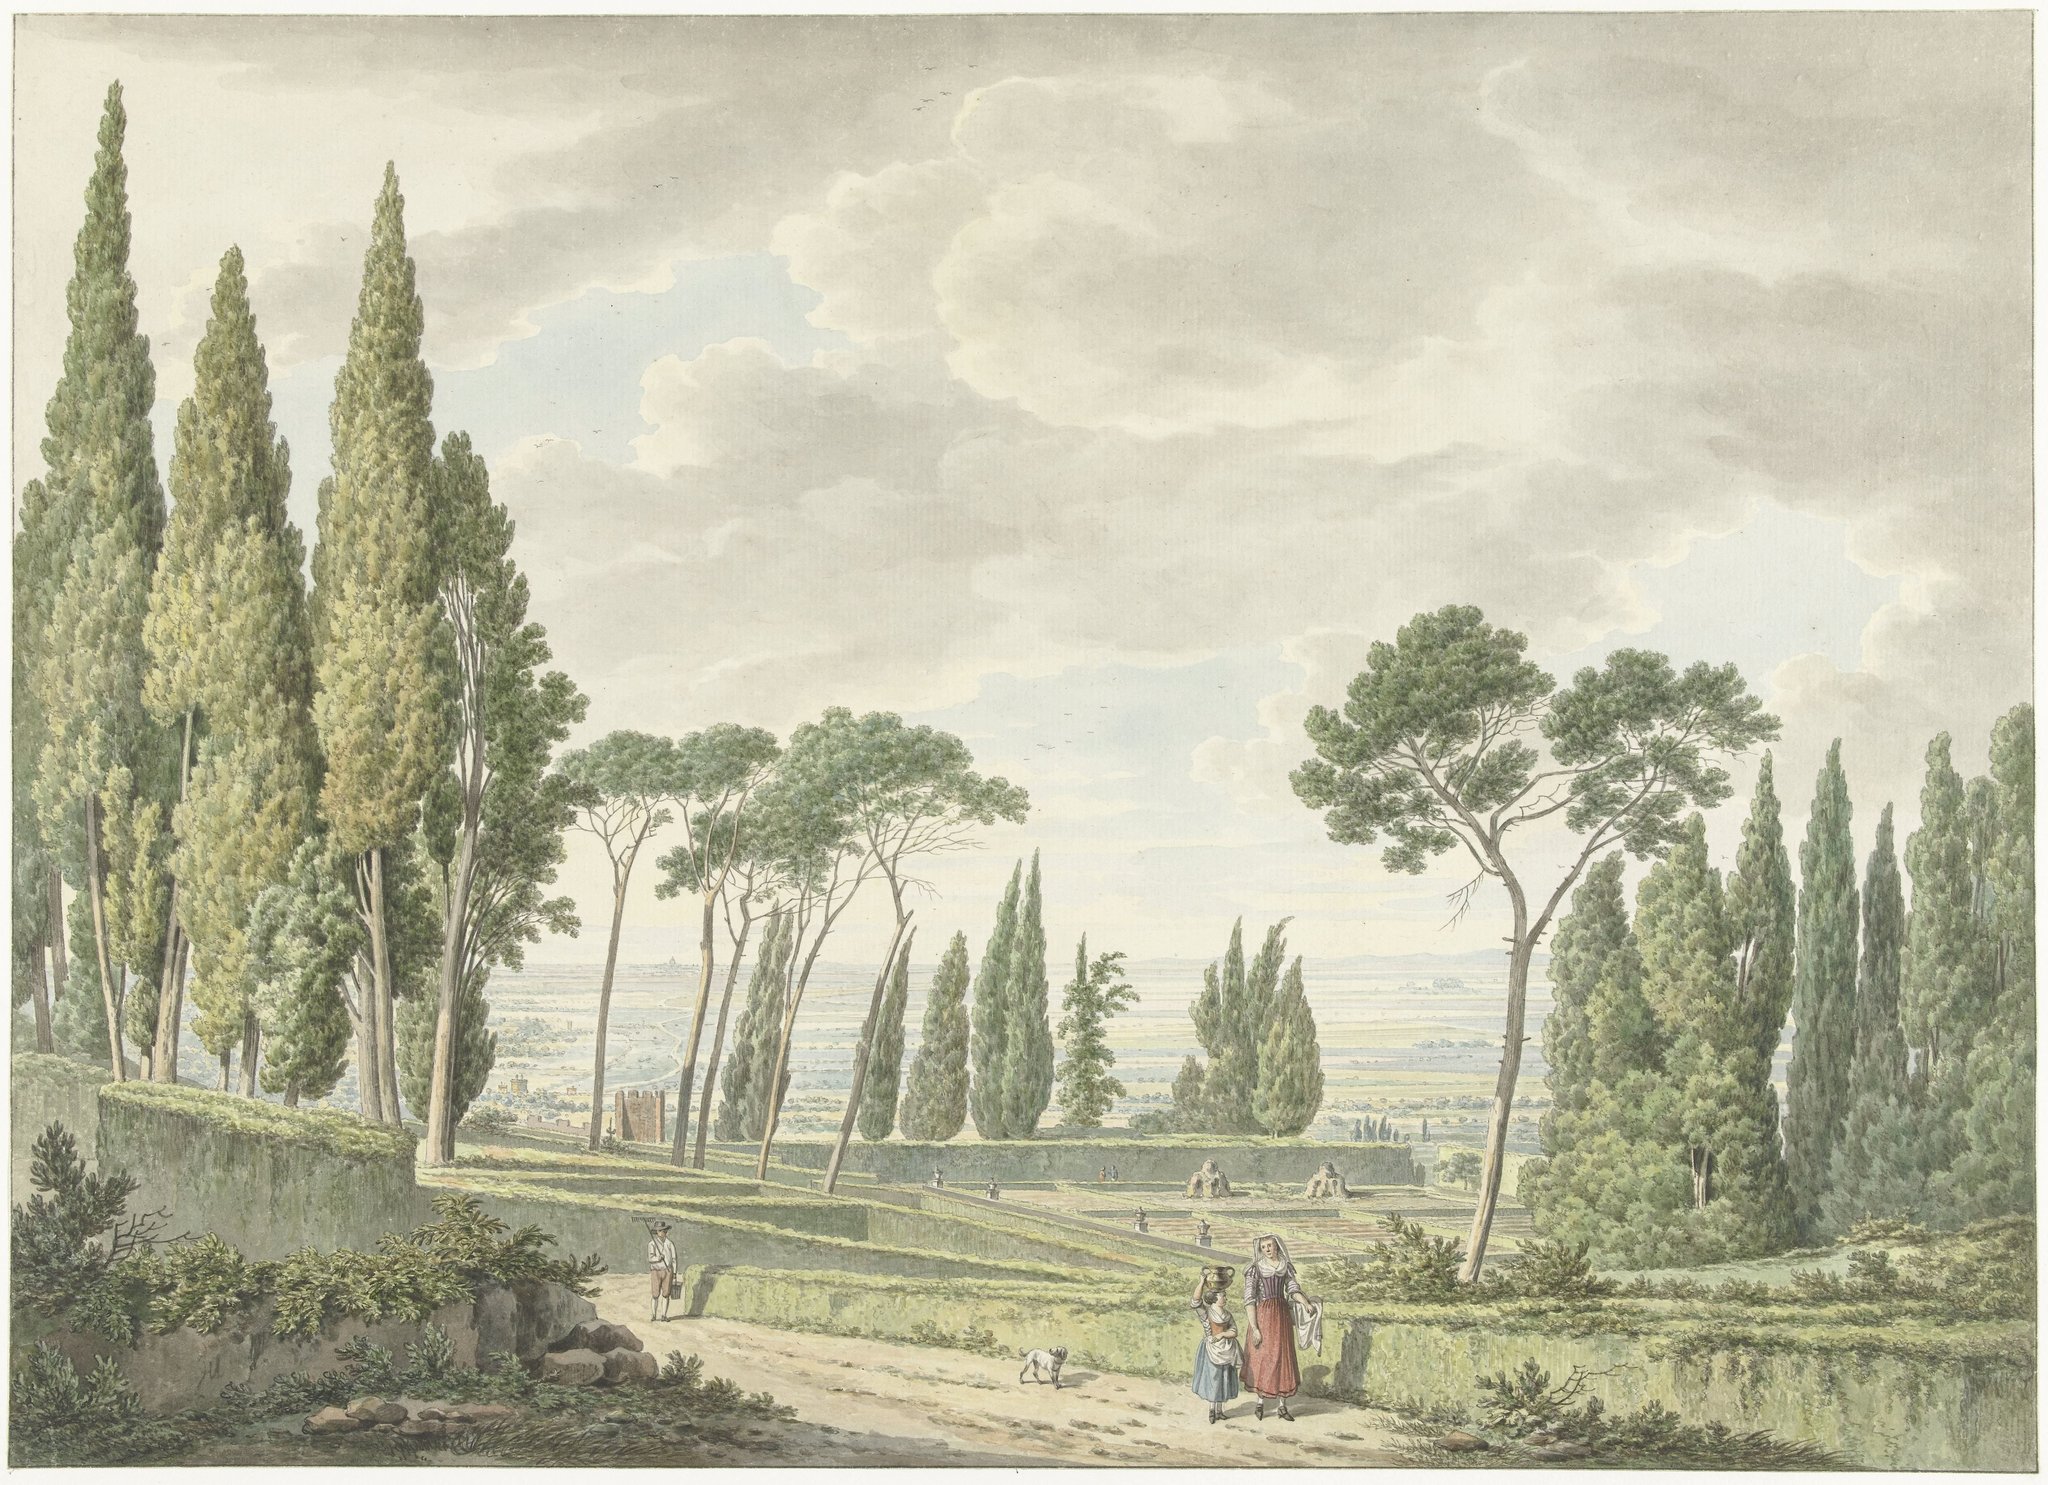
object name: watercolor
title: View of the terraces of the Villa d’Este in Tivoli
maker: daniël dupré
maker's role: draughtsman, print maker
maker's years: 1751-1817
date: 1791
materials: ink, paper, watercolor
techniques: brush, pen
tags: landscapes, italy, tivoli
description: Dupré made monochrome and coloured versions of his Italian views on commission, and possibly also for the these two scenes: in the coloured drawing a little dog has been added, and the woman and girl in the right foreground look out at the viewer.